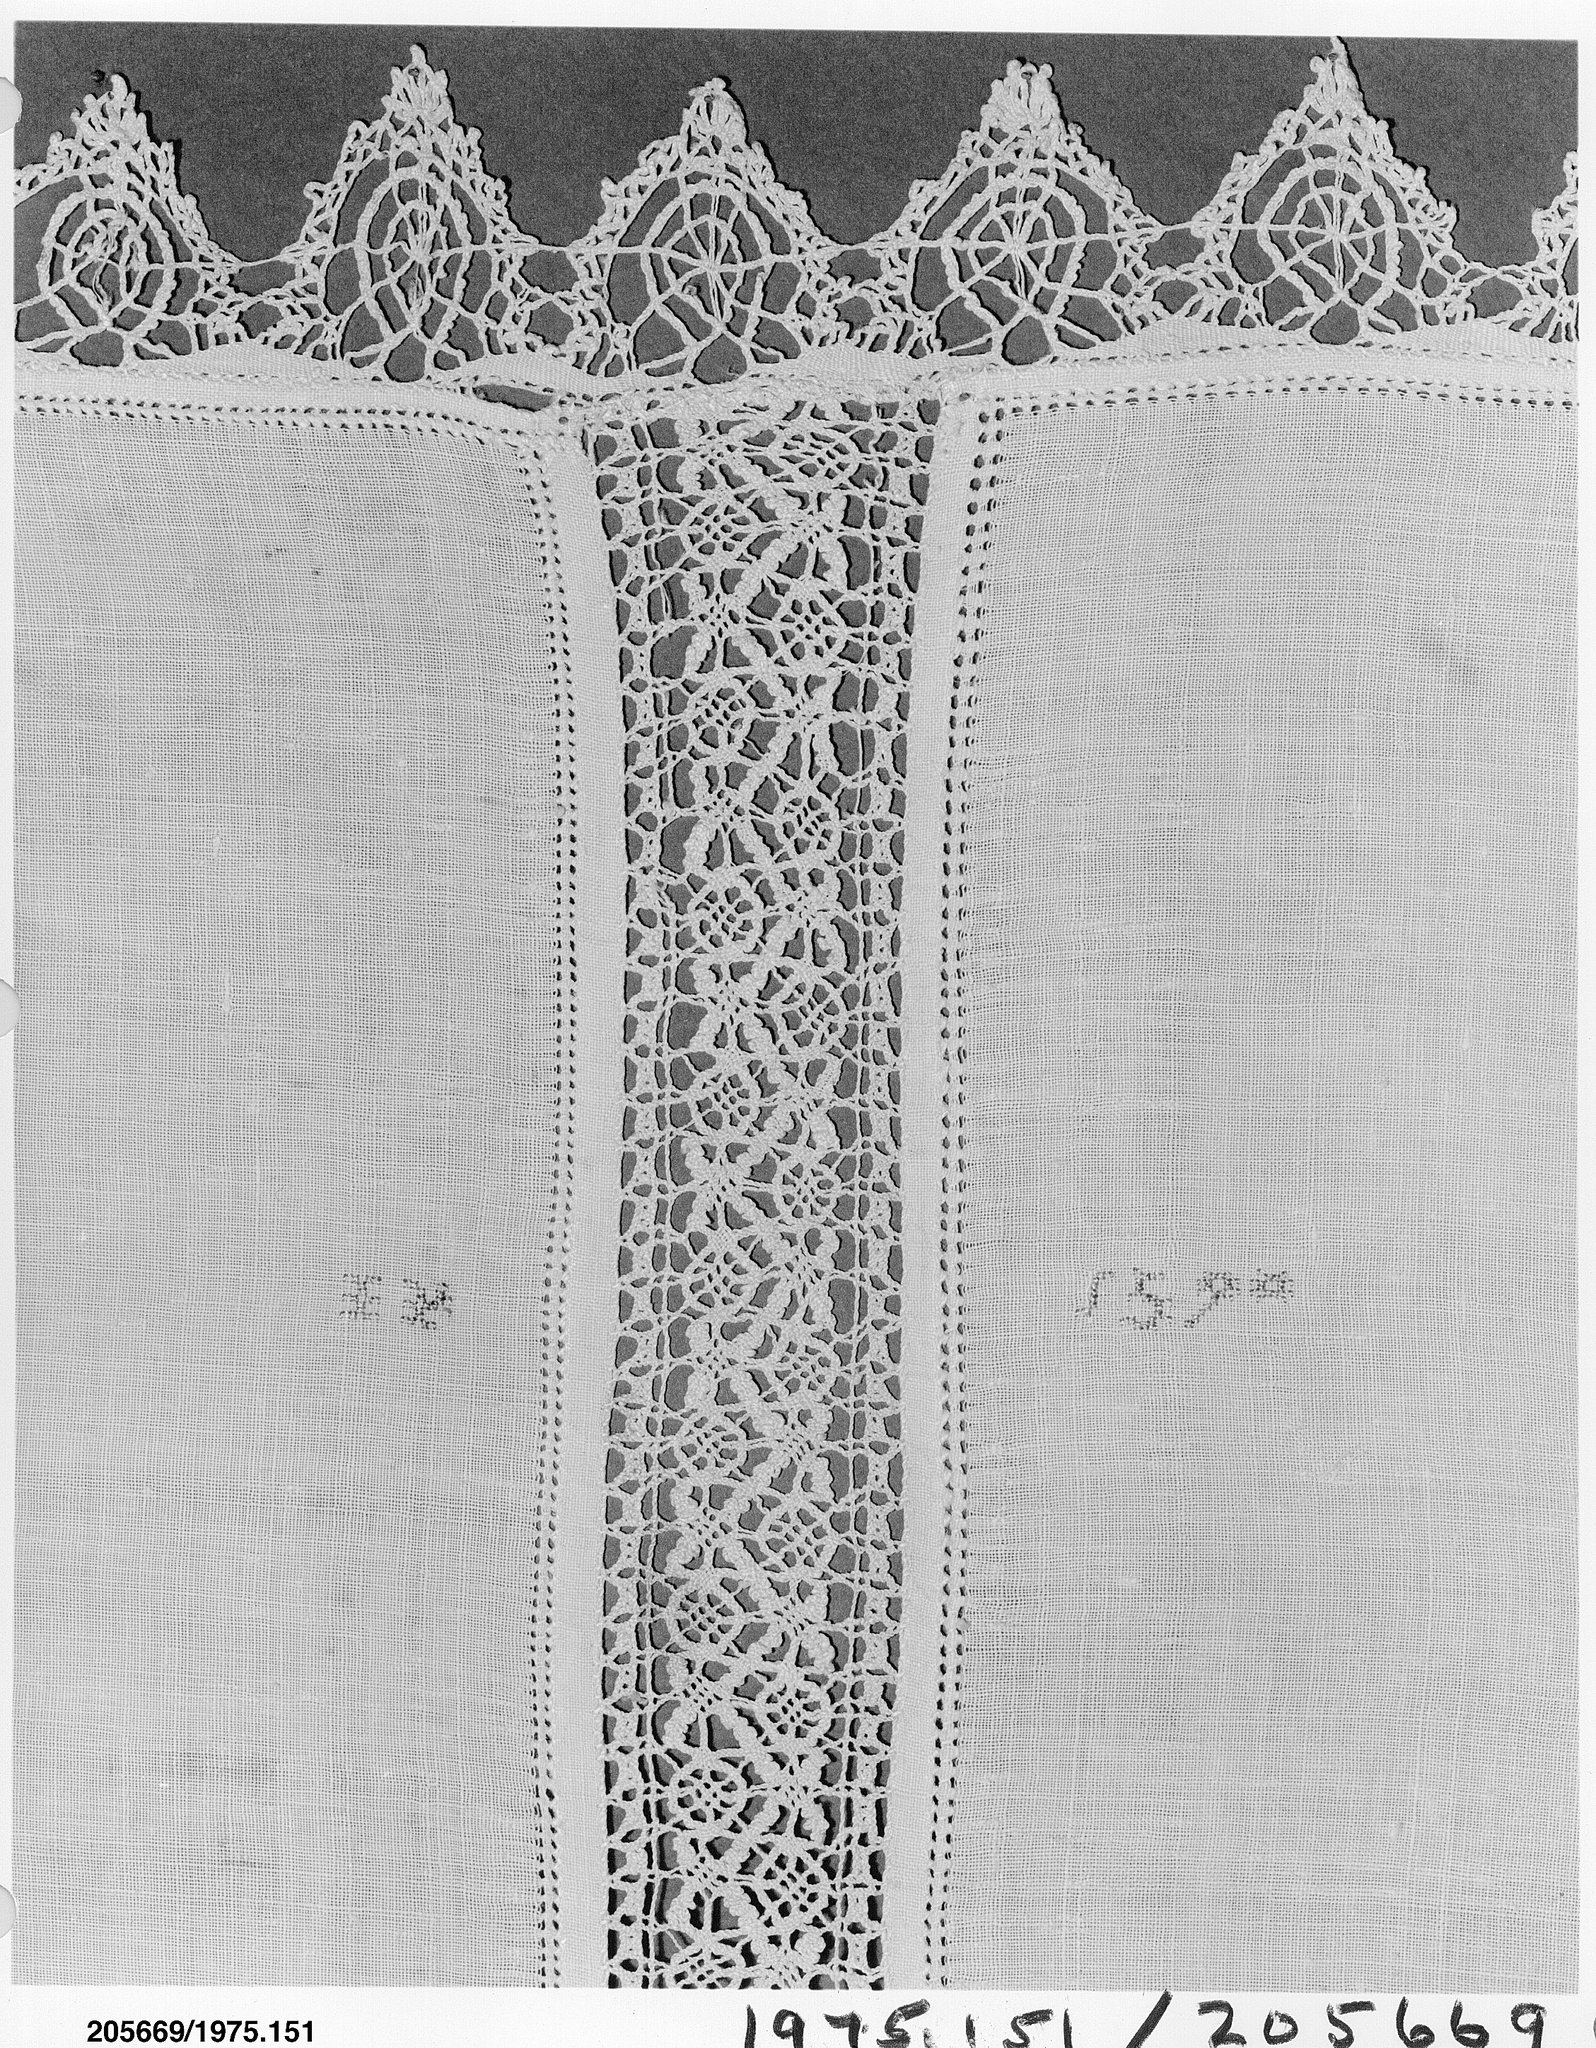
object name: tablecloth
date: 1590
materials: linen